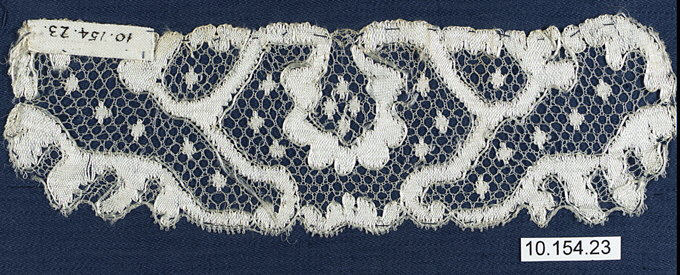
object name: cuff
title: Cuff (one of a pair)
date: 1801-1900